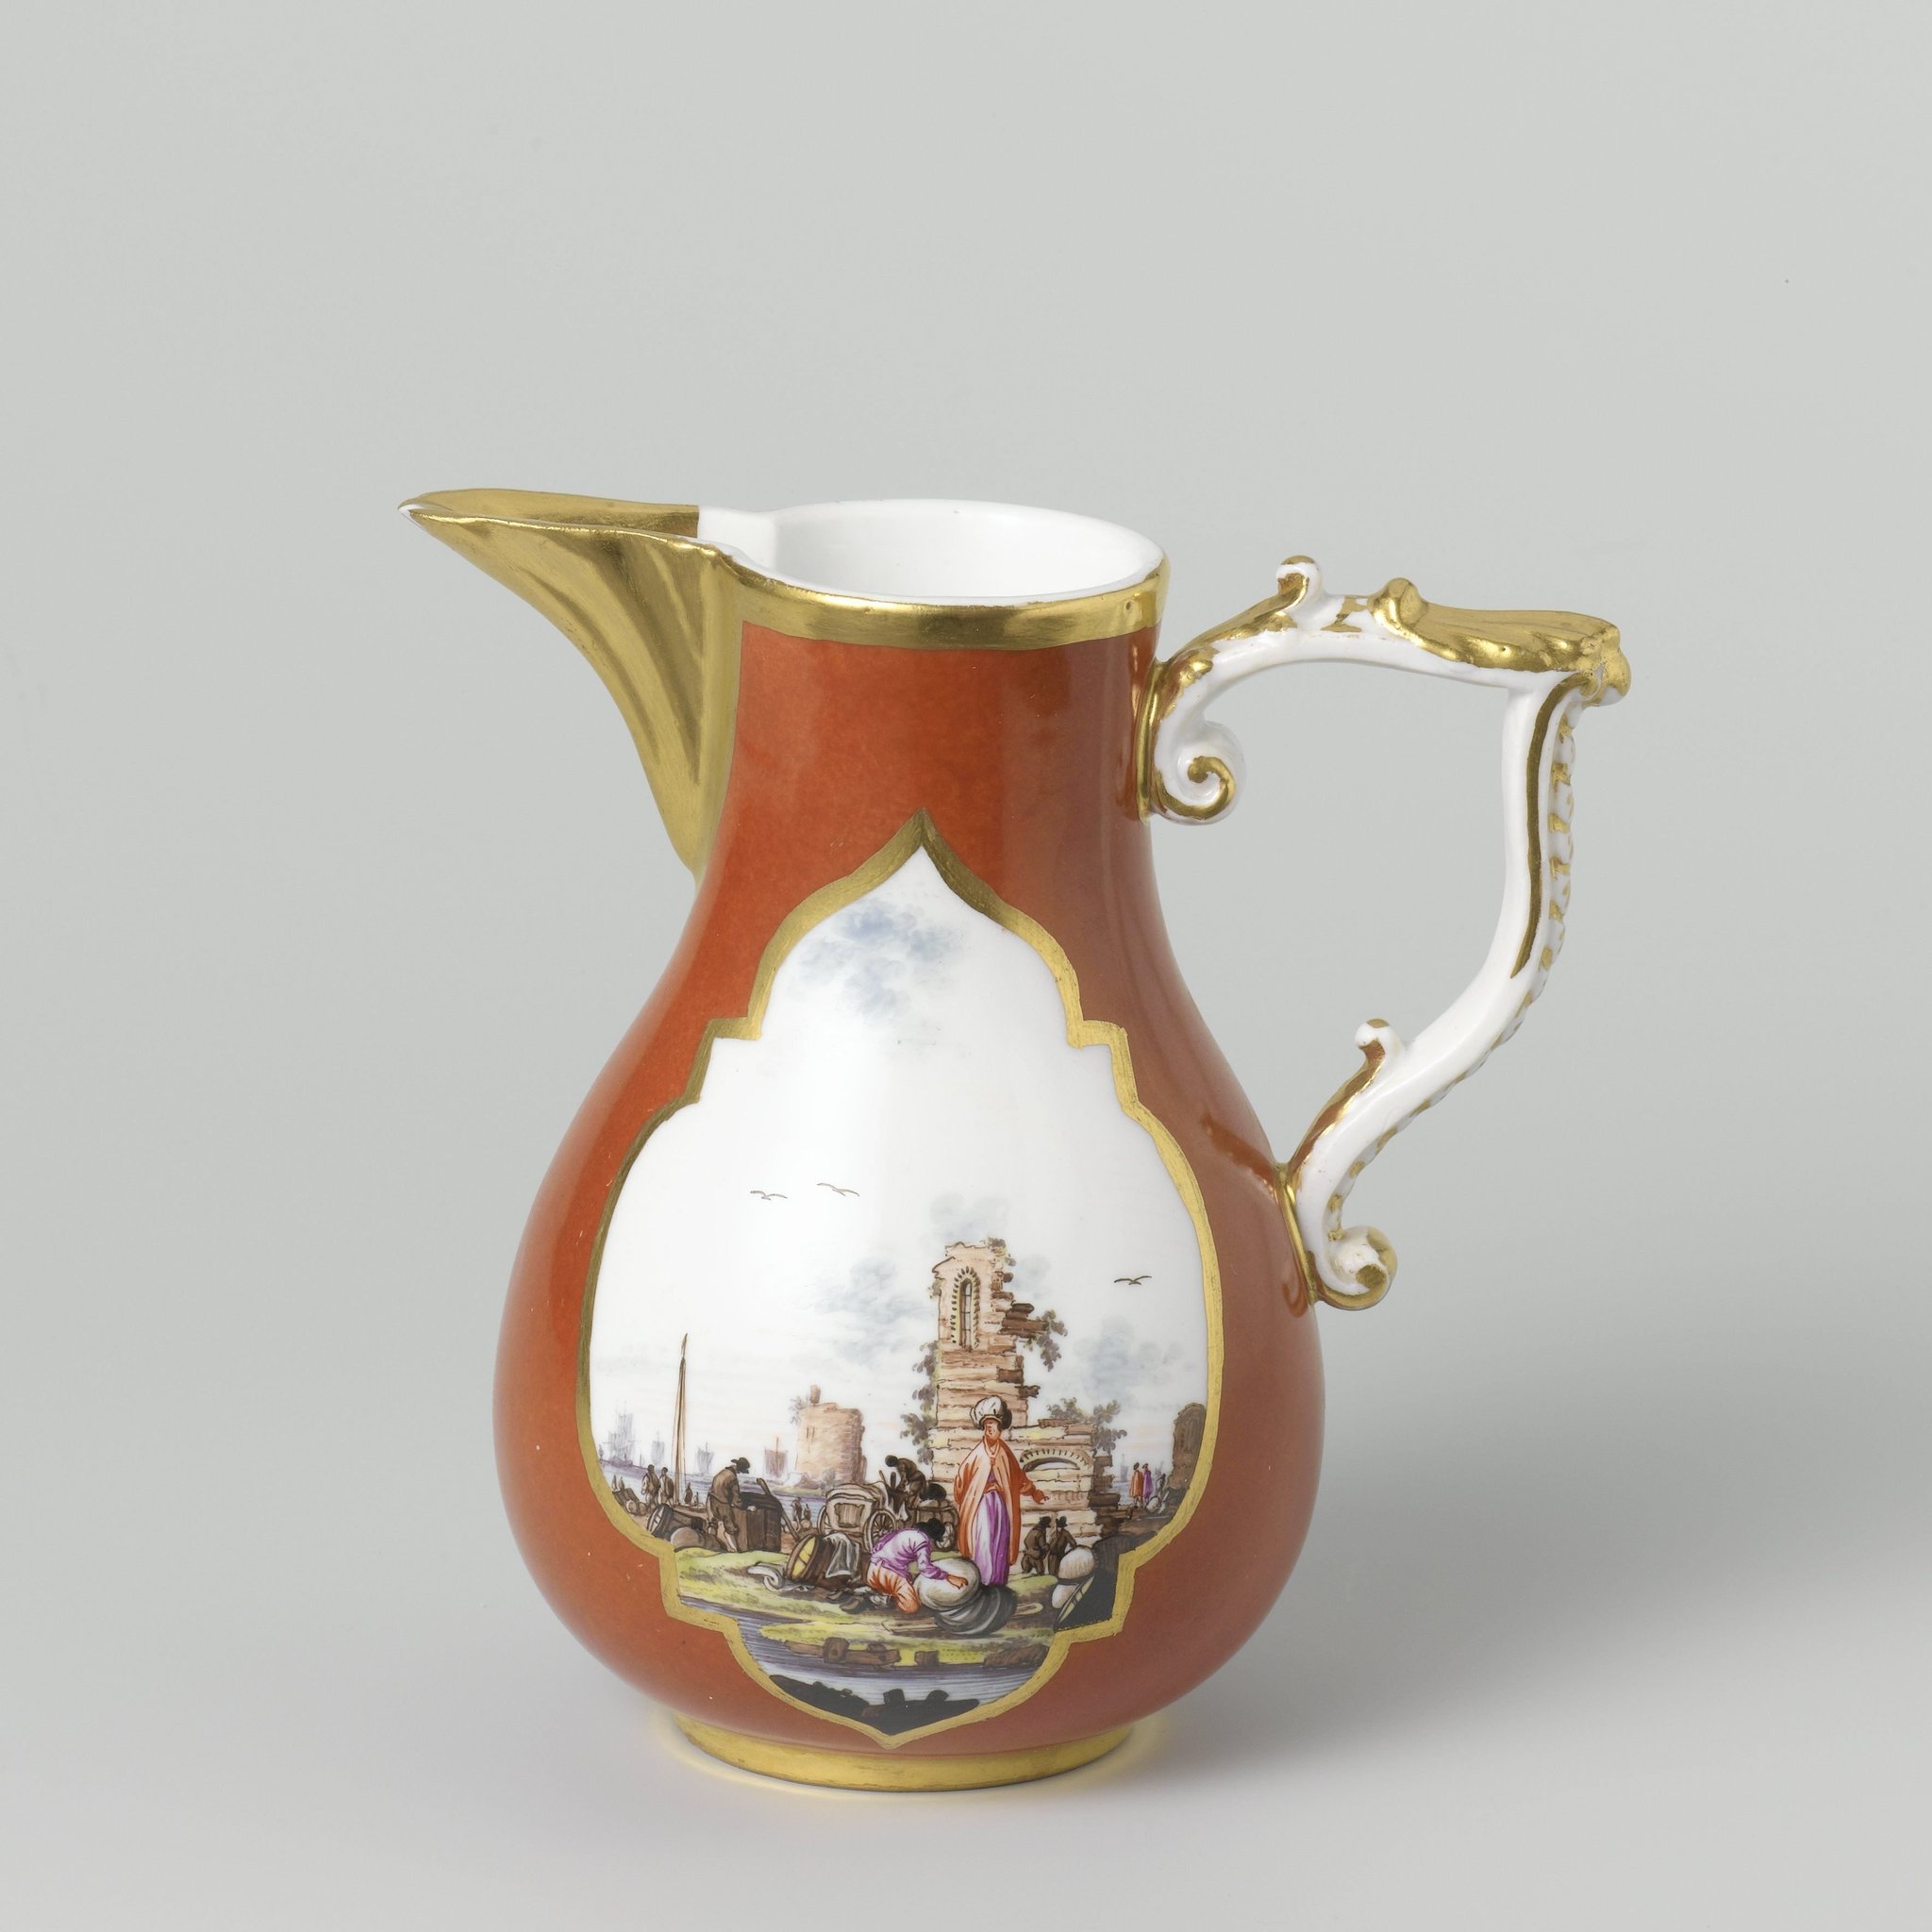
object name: eating drinking utensil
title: Melkkan, veelkleurig beschilderd met waterlandschappen in uitgespaarde vierpassen in een oranjerode fond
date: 1735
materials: porcelain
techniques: painted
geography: meissen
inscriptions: mark: ‘27’, mold mark, factory mark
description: Melkkan van beschilderd porselein. De melkkan is bedekt met een oranjerode fond, waarin accoladevormige vierpassen zijn uitgespaard met (water)landschappen met europese figuren, soms bij balen en schepen. De melkkan is gemerkt. Het deksel ontbreekt.